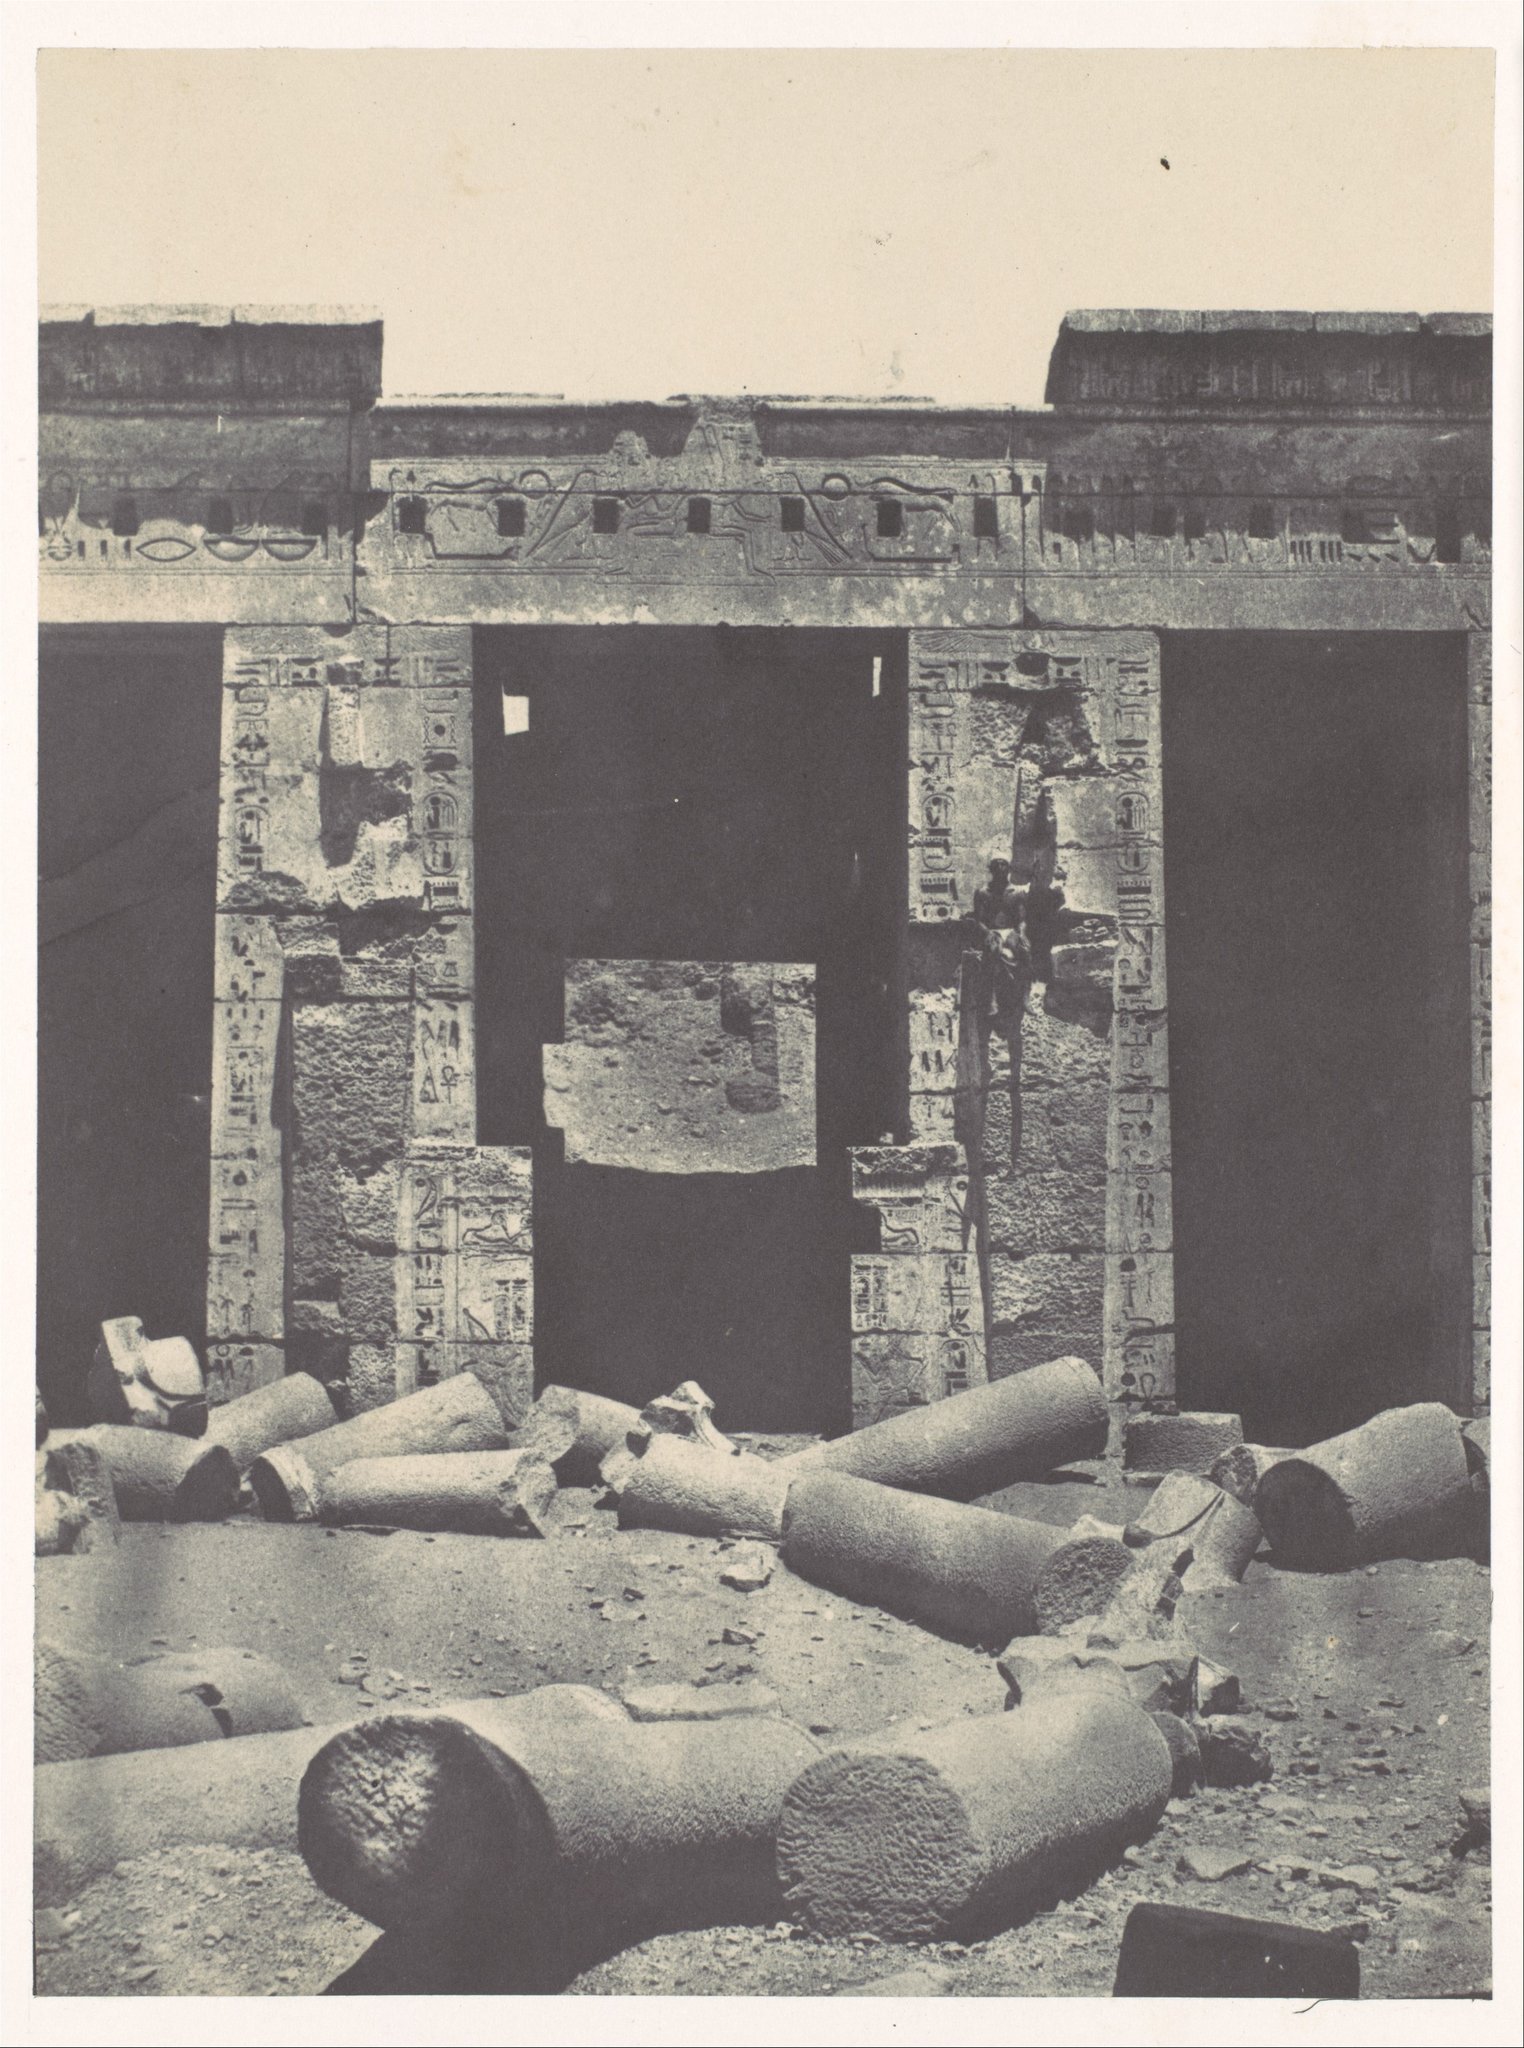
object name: photograph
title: Thebes. Médinet-Habou. Partie orientale du Péristyle du Palais de Ramsès-Méiamoun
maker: maxime du camp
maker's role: artist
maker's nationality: french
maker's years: 1822-1894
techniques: paper negative, salted paper print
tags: columns,ruins